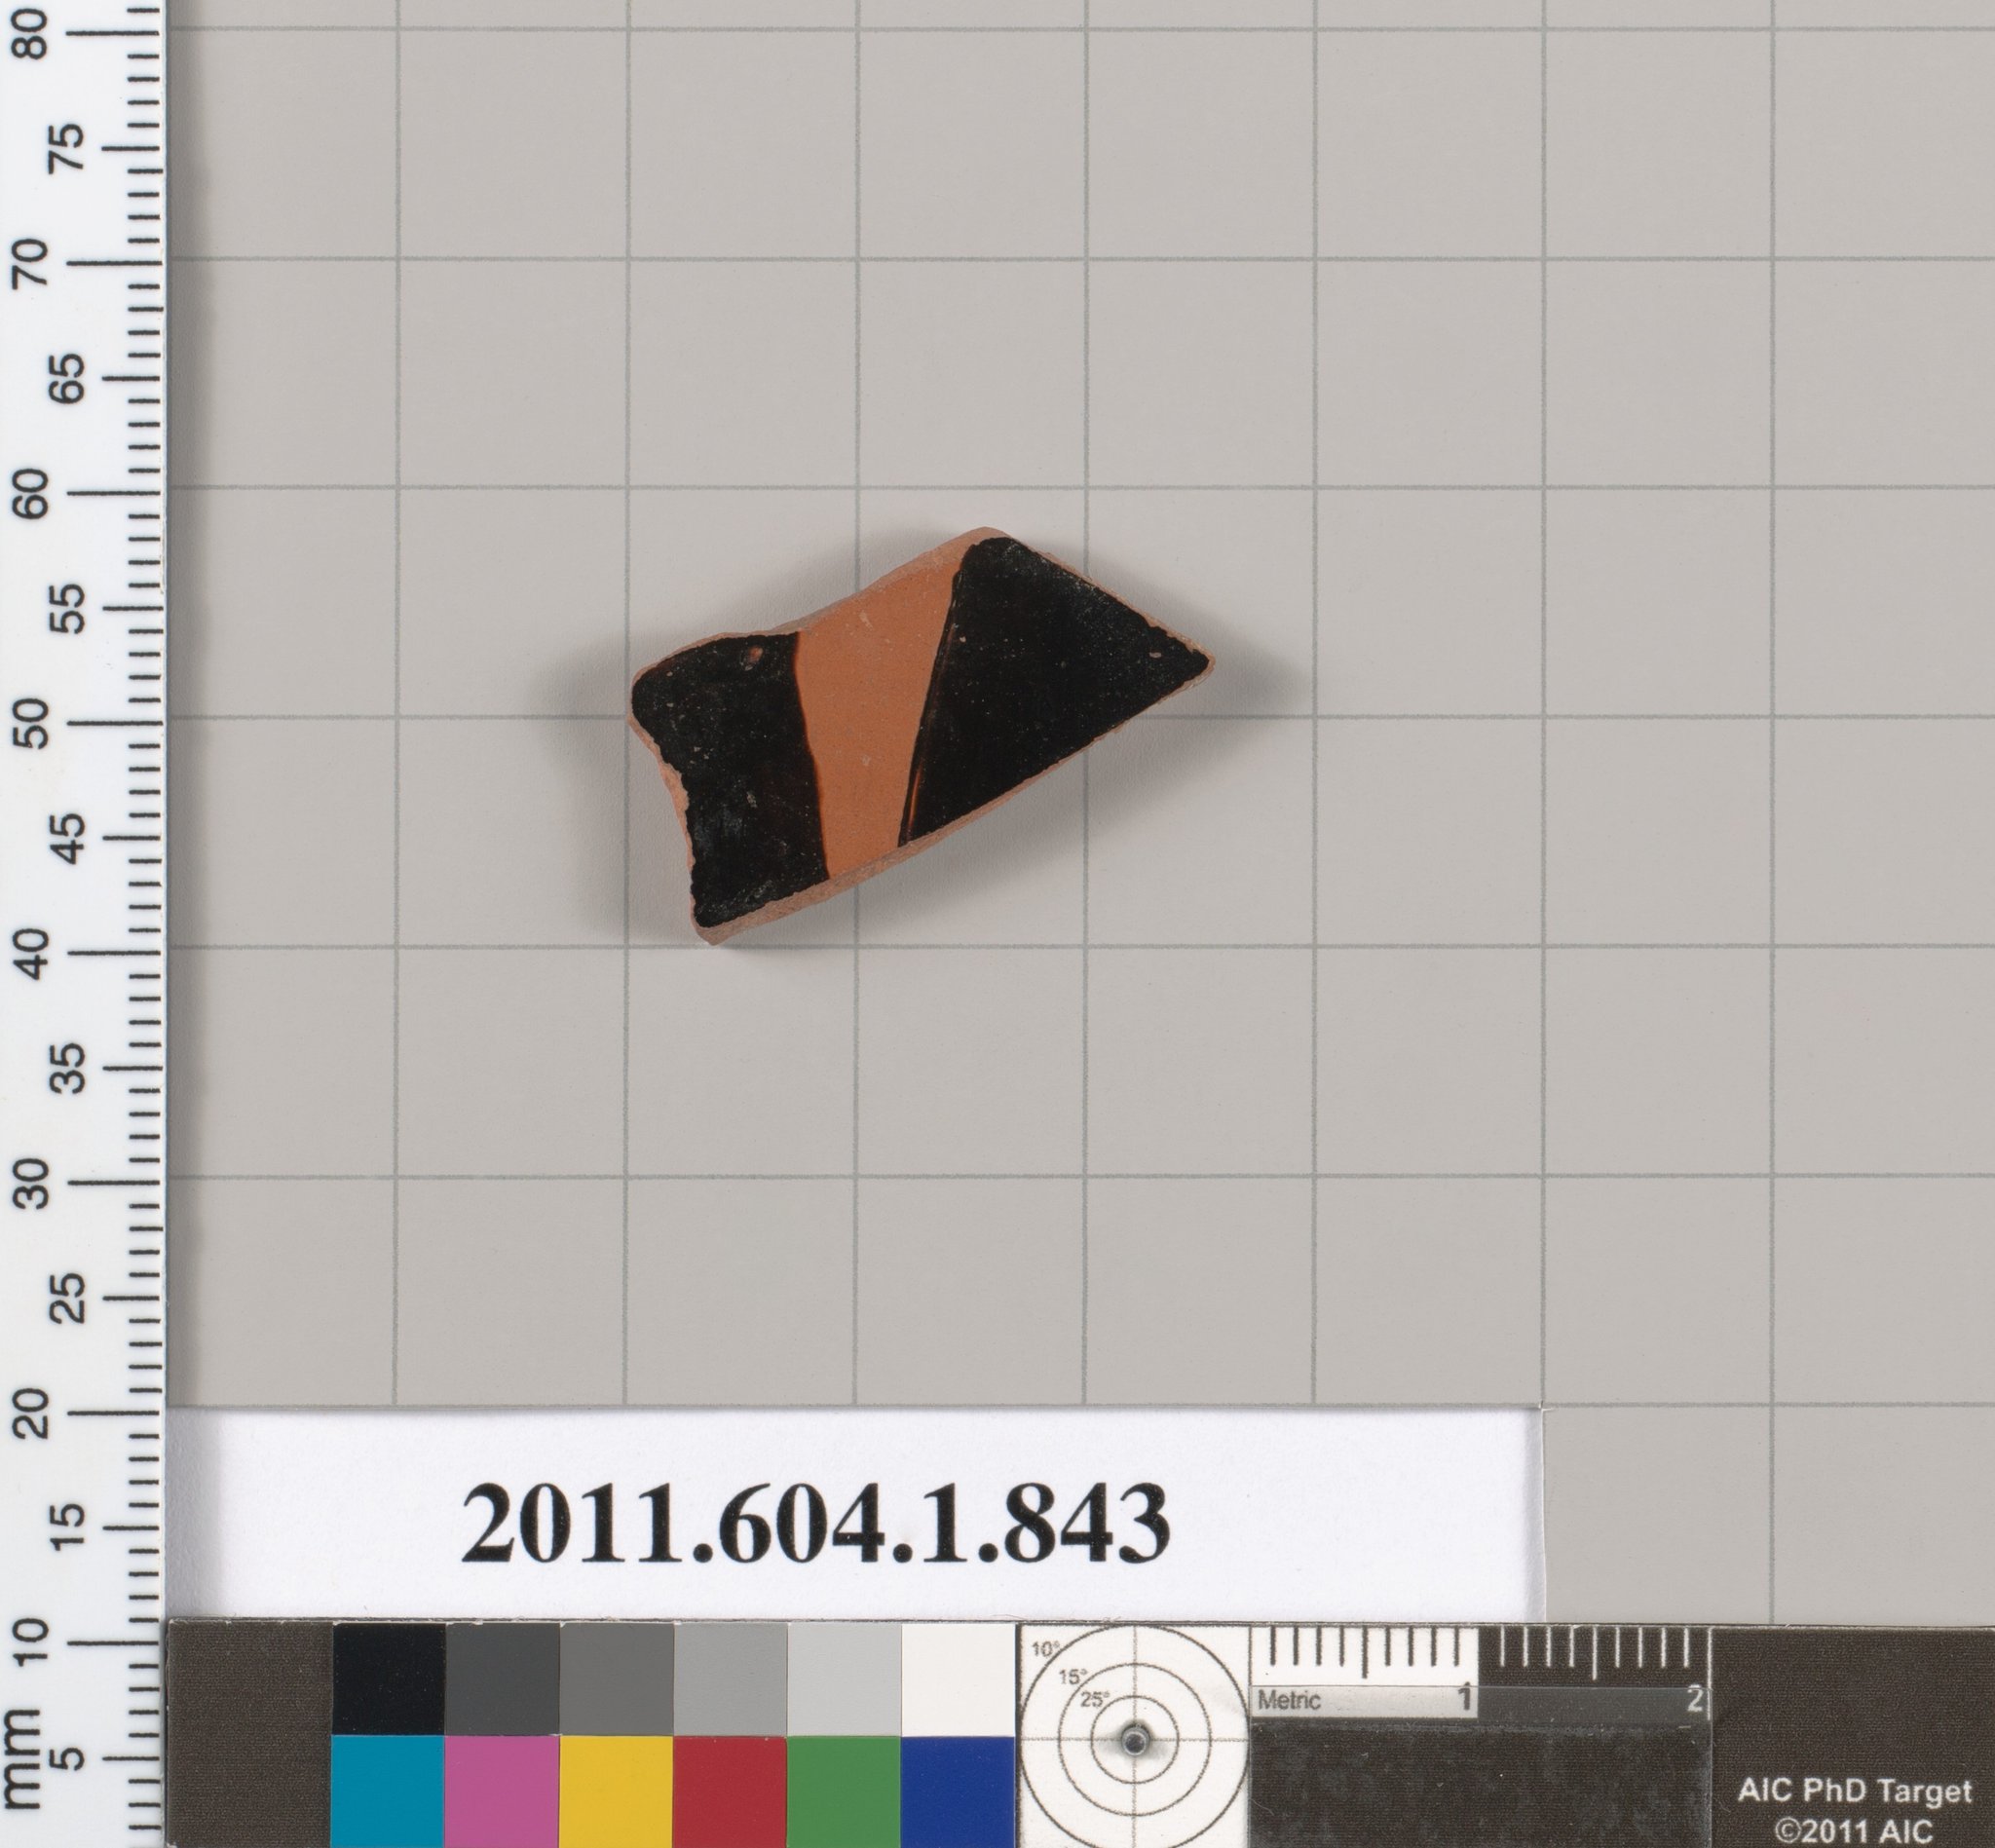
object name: kylix fragment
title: Terracotta fragment of a kylix (drinking cup)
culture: greek, attic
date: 475-451 BCE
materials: terracotta